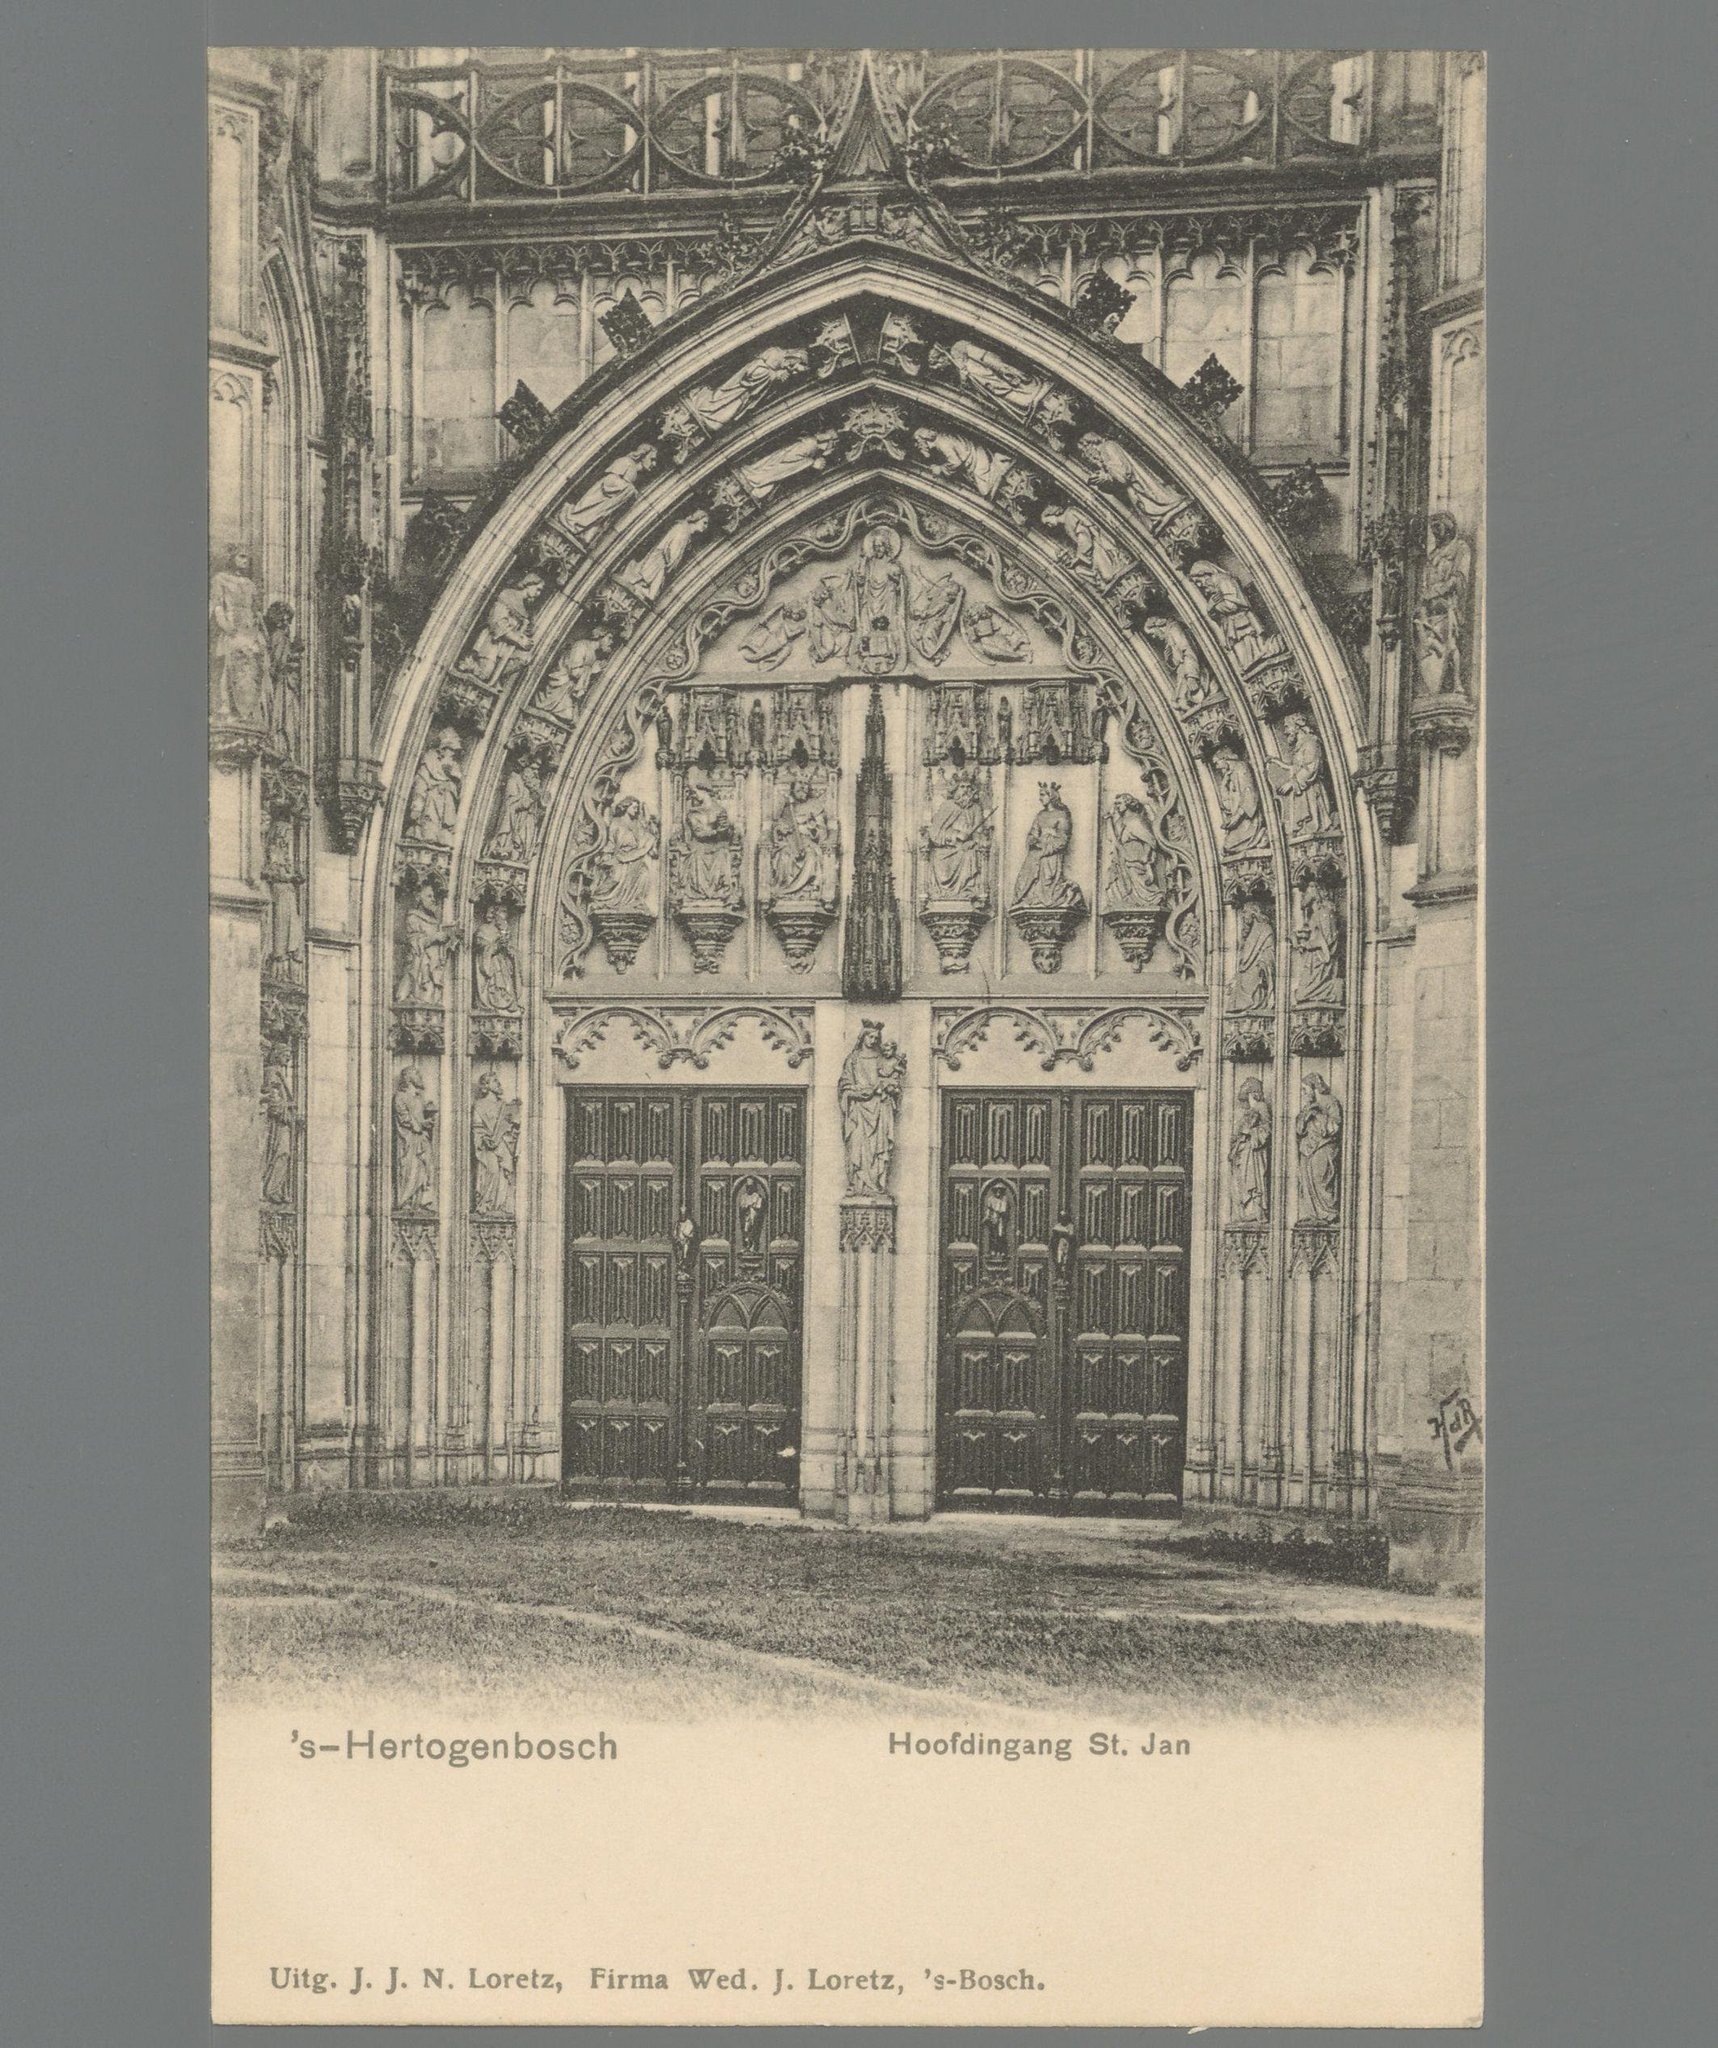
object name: ansichtkaart, prentbriefkaart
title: 's-Hertogenbosch. Hoofdingang St. Jan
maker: Anonymous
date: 1900-1905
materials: cardboard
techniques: photograph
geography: den bosch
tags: parts of church exterior and annexes: portal